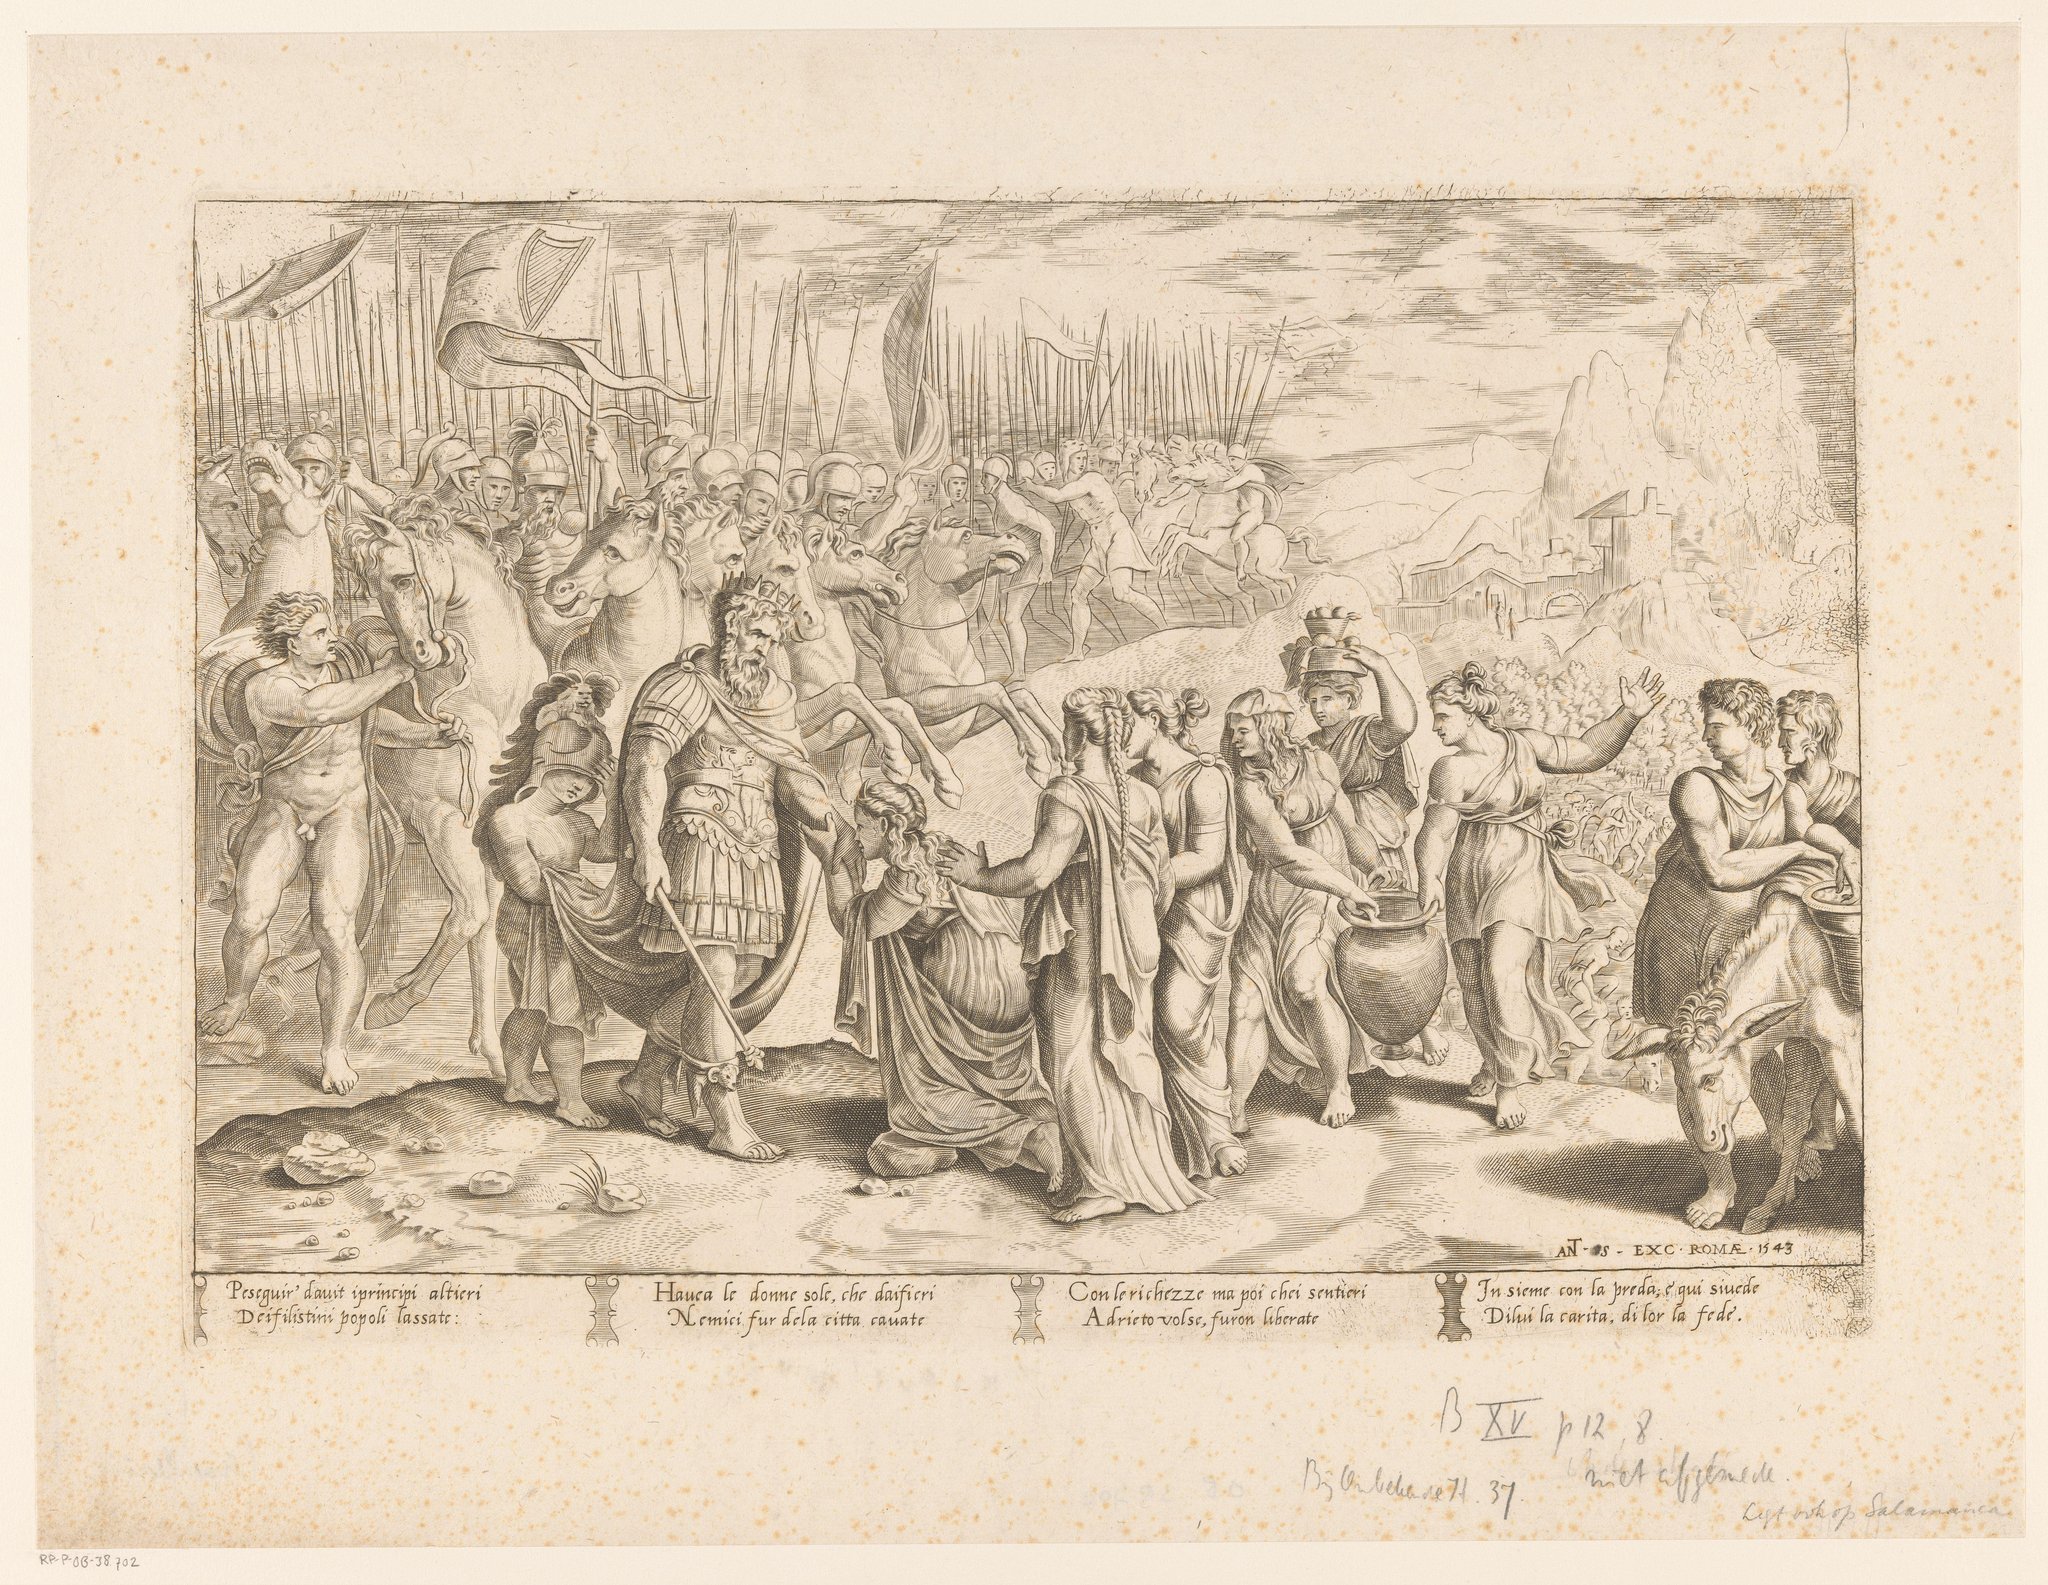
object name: print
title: Abigaïl vraagt David om vergeving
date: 1543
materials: paper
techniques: engraving, etching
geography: italy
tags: city-view, and landscape with man-made constructions, meeting of david and abigail, who kneels before him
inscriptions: collector's mark: Lugt 2228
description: Abigaïl knielt voor David neer en vraagt hem om vergeving voor het gedrag van haar man Nabal, die David voedsel weigerde. Achter David staan zijn medestrijders. Achter Abigaïl haar dienaren en dienaressen met voedsel. Italiaanse tekst in vier kolommen in ondermarge.